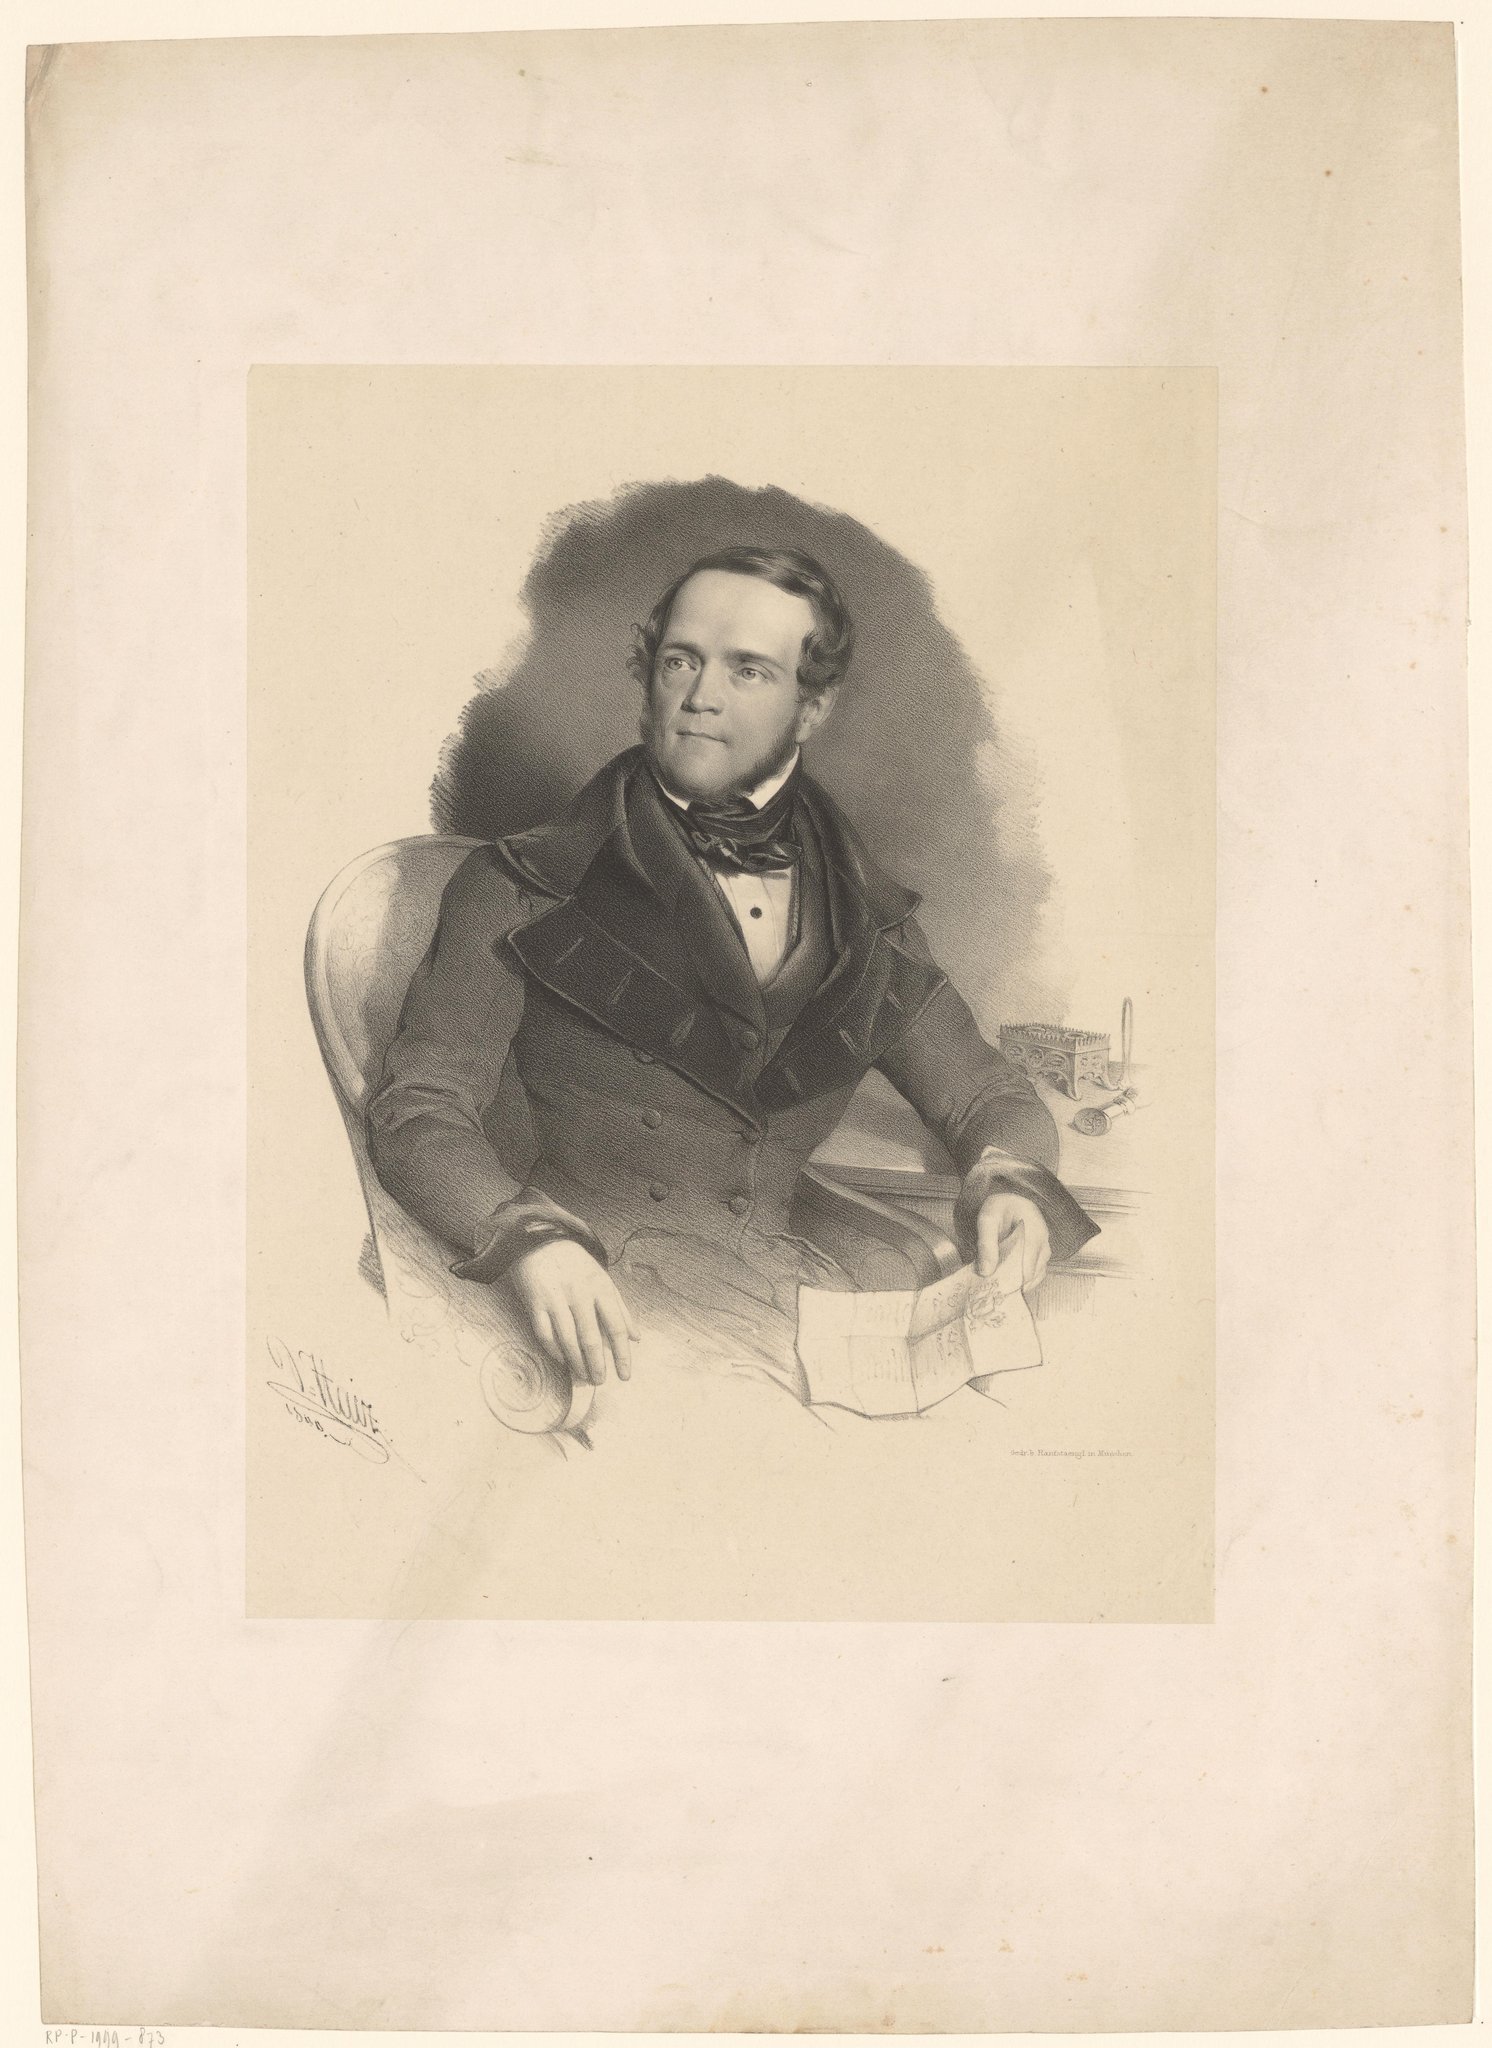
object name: print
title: Portret van een onbekende man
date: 1840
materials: paper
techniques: lithograph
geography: munich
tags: armchair, seat, adult man, historical persons, letter, envelope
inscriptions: collector's mark: Lugt 2760, collector's mark: Lugt 2228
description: Een man in zwarte mantel zit op een stoel met een brief in zijn linkerhand. Kniestuk. Op de tafel naast hem een zegel.